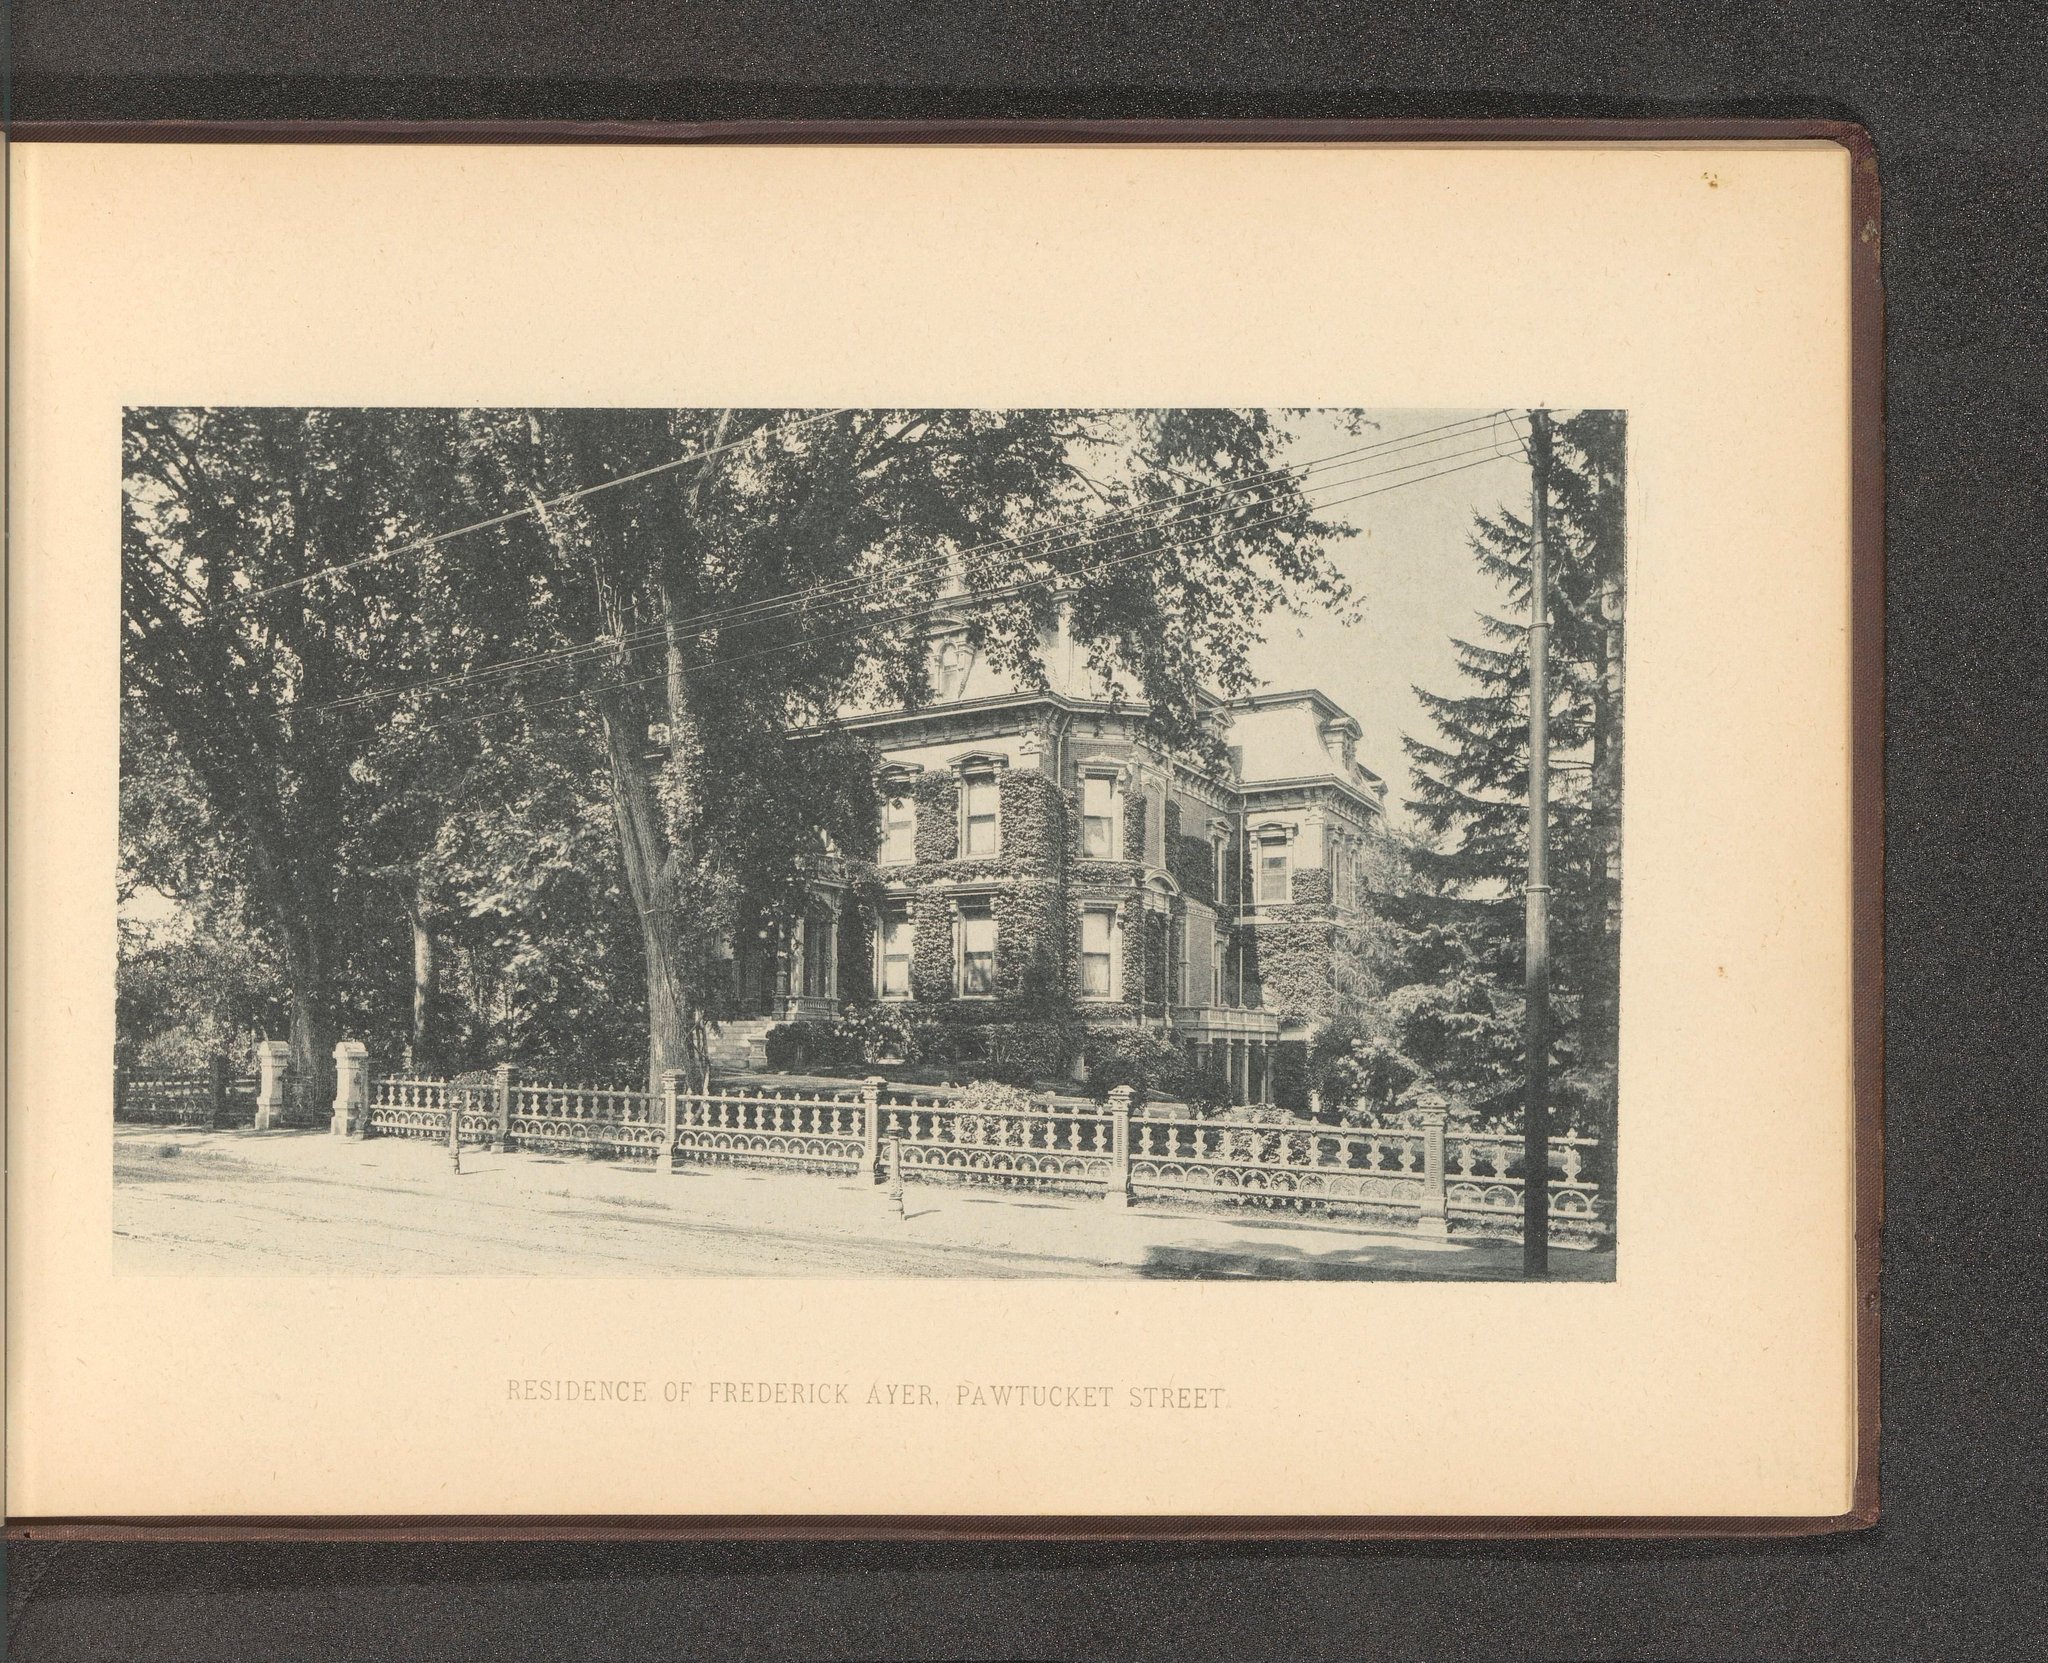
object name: photomechanical print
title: Residence of Frederick Ayer, Pawtucket street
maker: Anonymous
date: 1887-1892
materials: paper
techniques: photograph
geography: lowell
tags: villa, façade (of house or building)